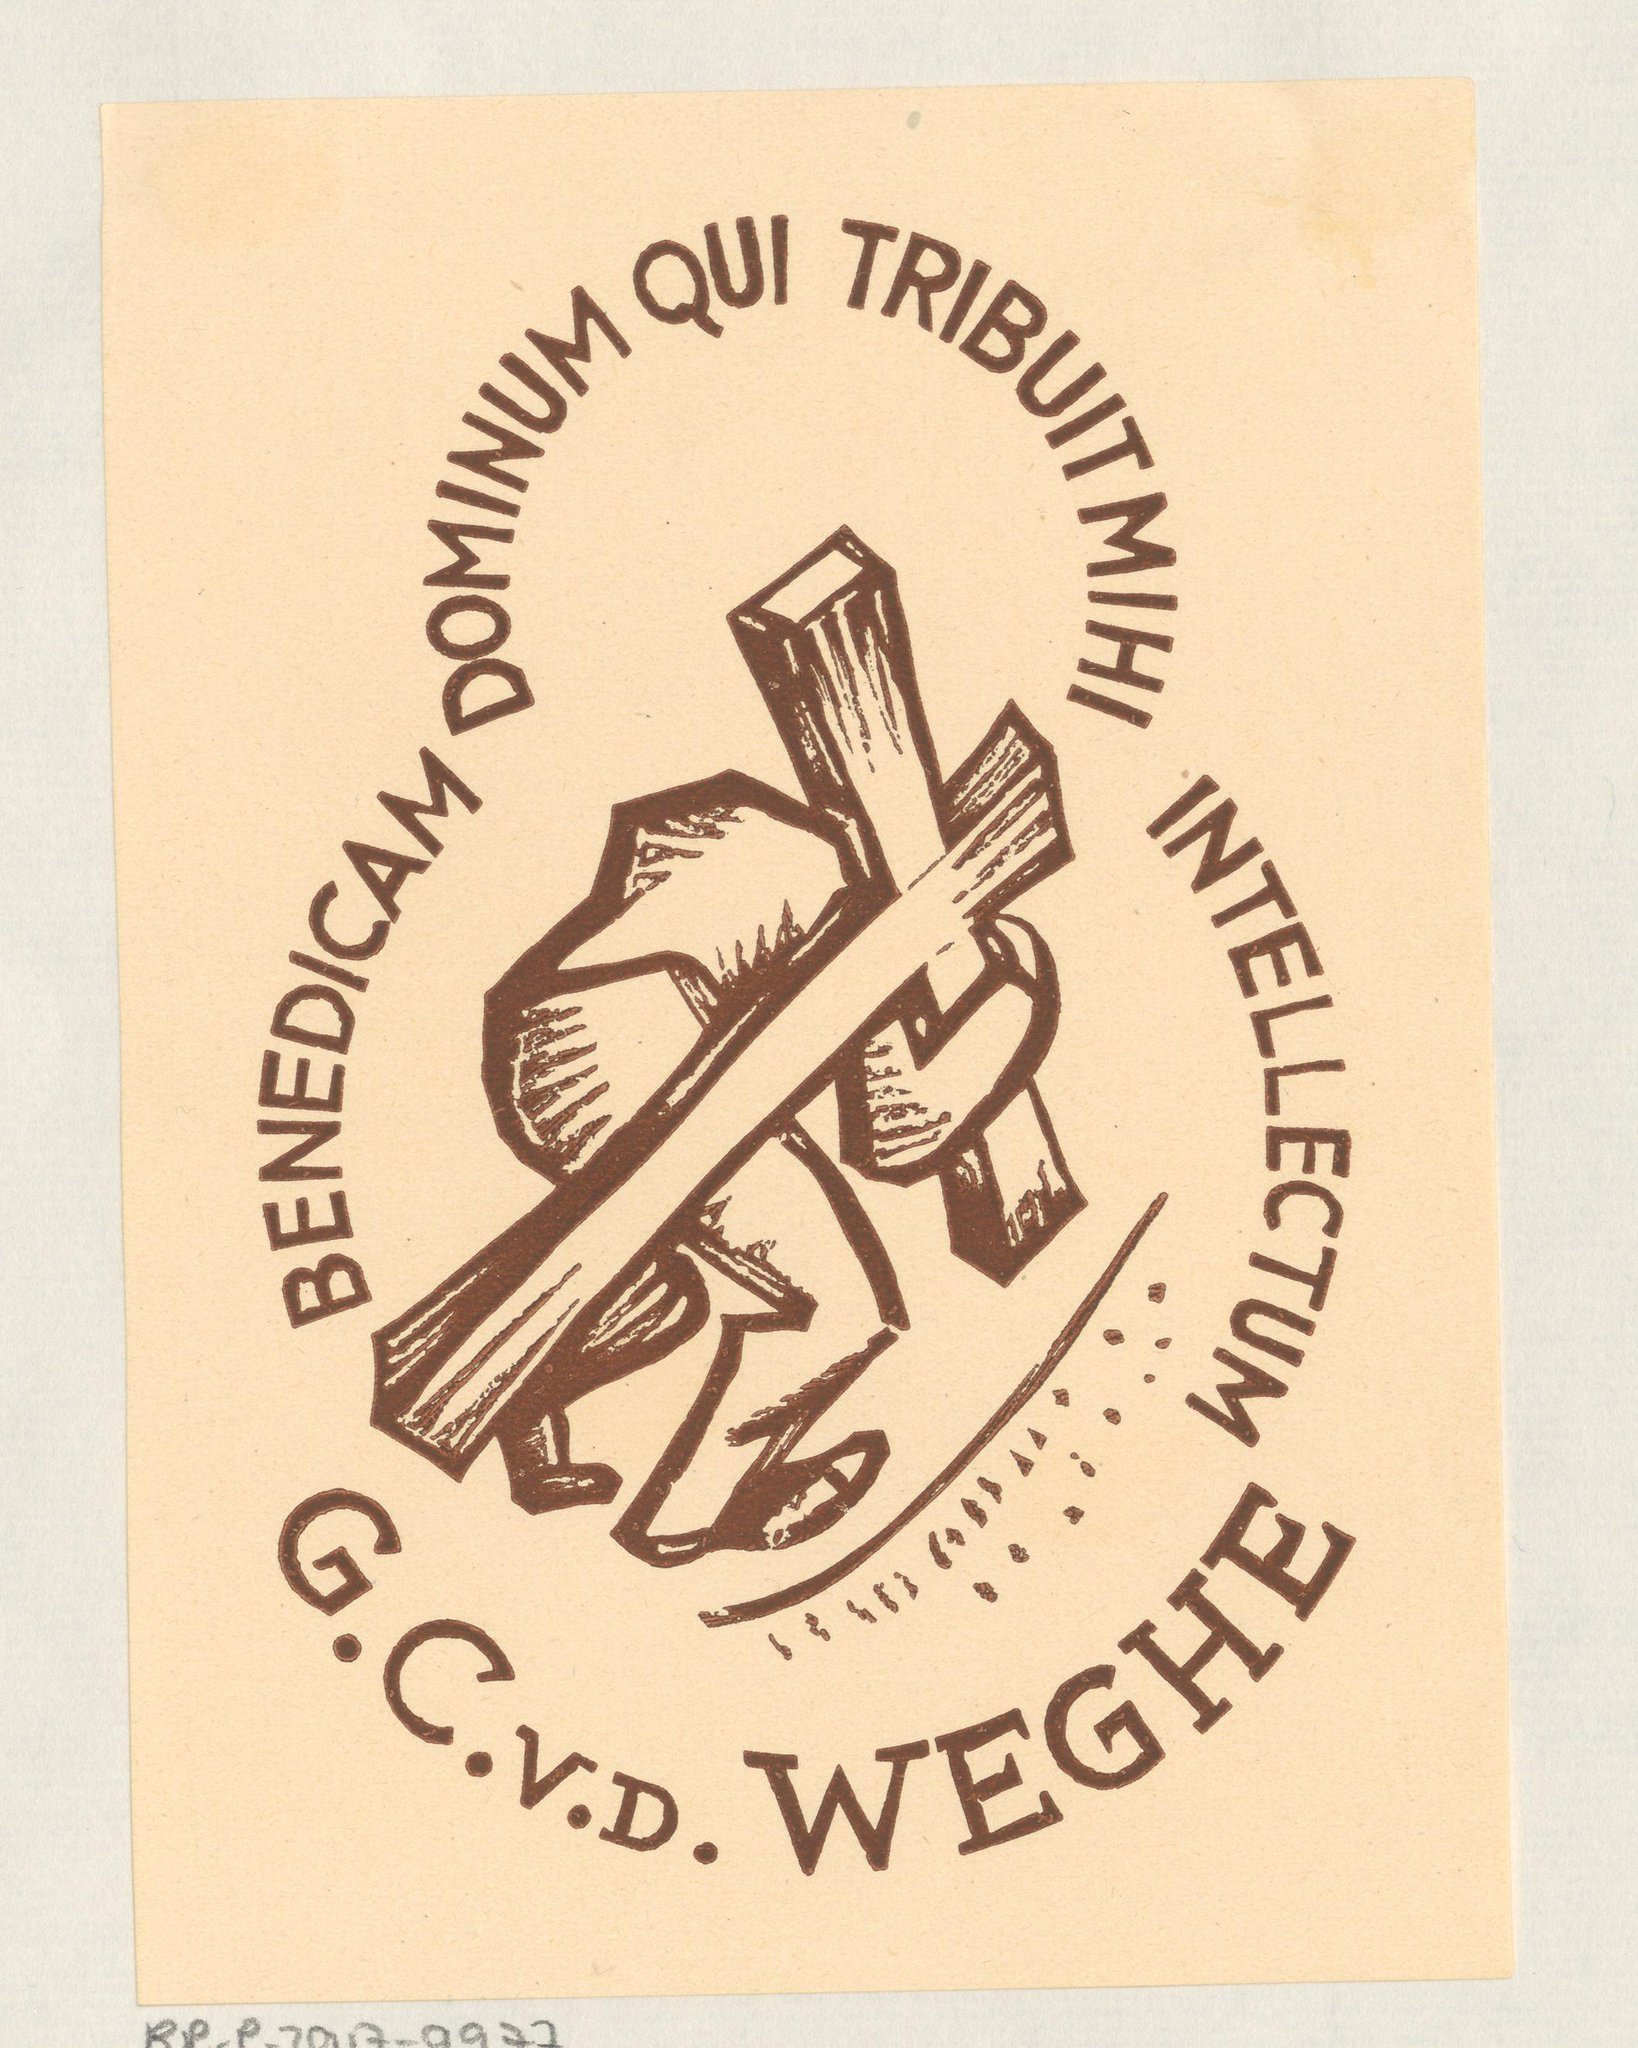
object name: bookplate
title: Benedicam dominum qui tribuit mihi intellectum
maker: Anonymous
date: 1945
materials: paper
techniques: printing block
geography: netherlands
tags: carrying something, the cross ~ symbols of christ